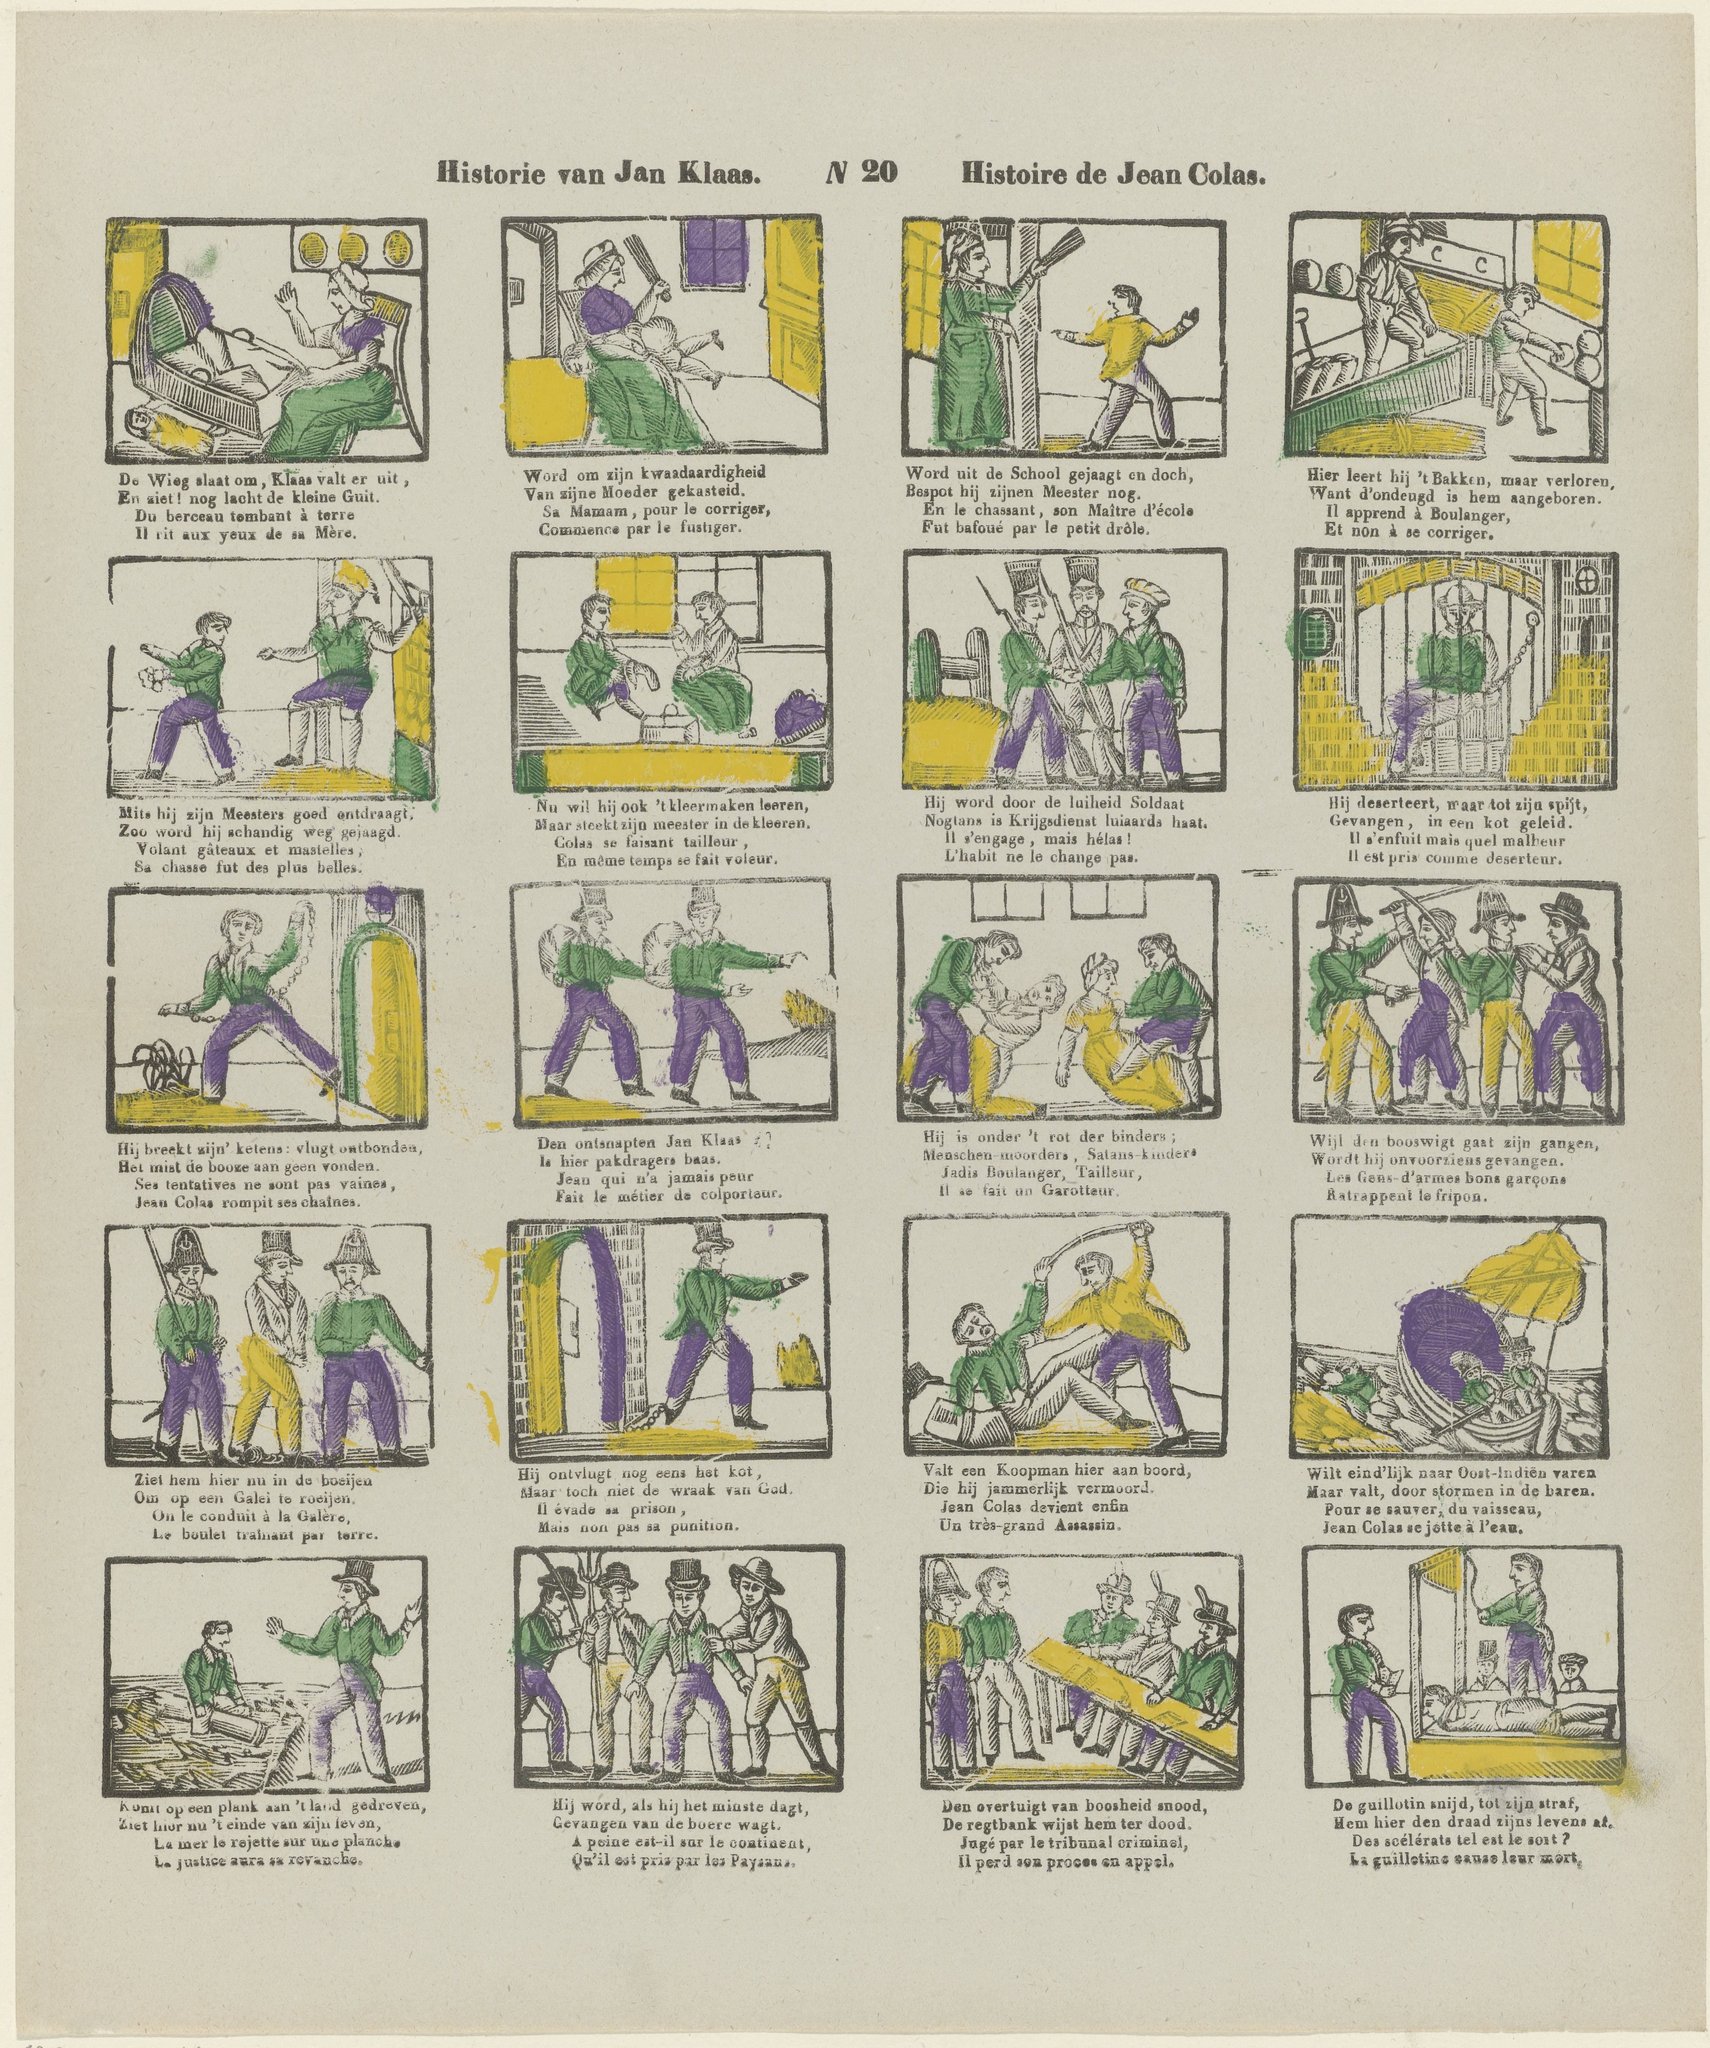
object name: print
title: Historie van Jan Klaas / Histoire de Jean Colas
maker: Anonymous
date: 1856-1900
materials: paper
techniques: colour, letterpress printing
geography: turnhout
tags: tales and fairy tales, human life divided into stages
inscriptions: collector's mark: Lugt 2760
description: Blad met 20 voorstellingen over het leven en bezigheden van een schurk (Jan Klaas). Onder elke afbeelding een tweeregelig vers in het Nederlands en in het Frans. Genummerd midden boven: N 20.